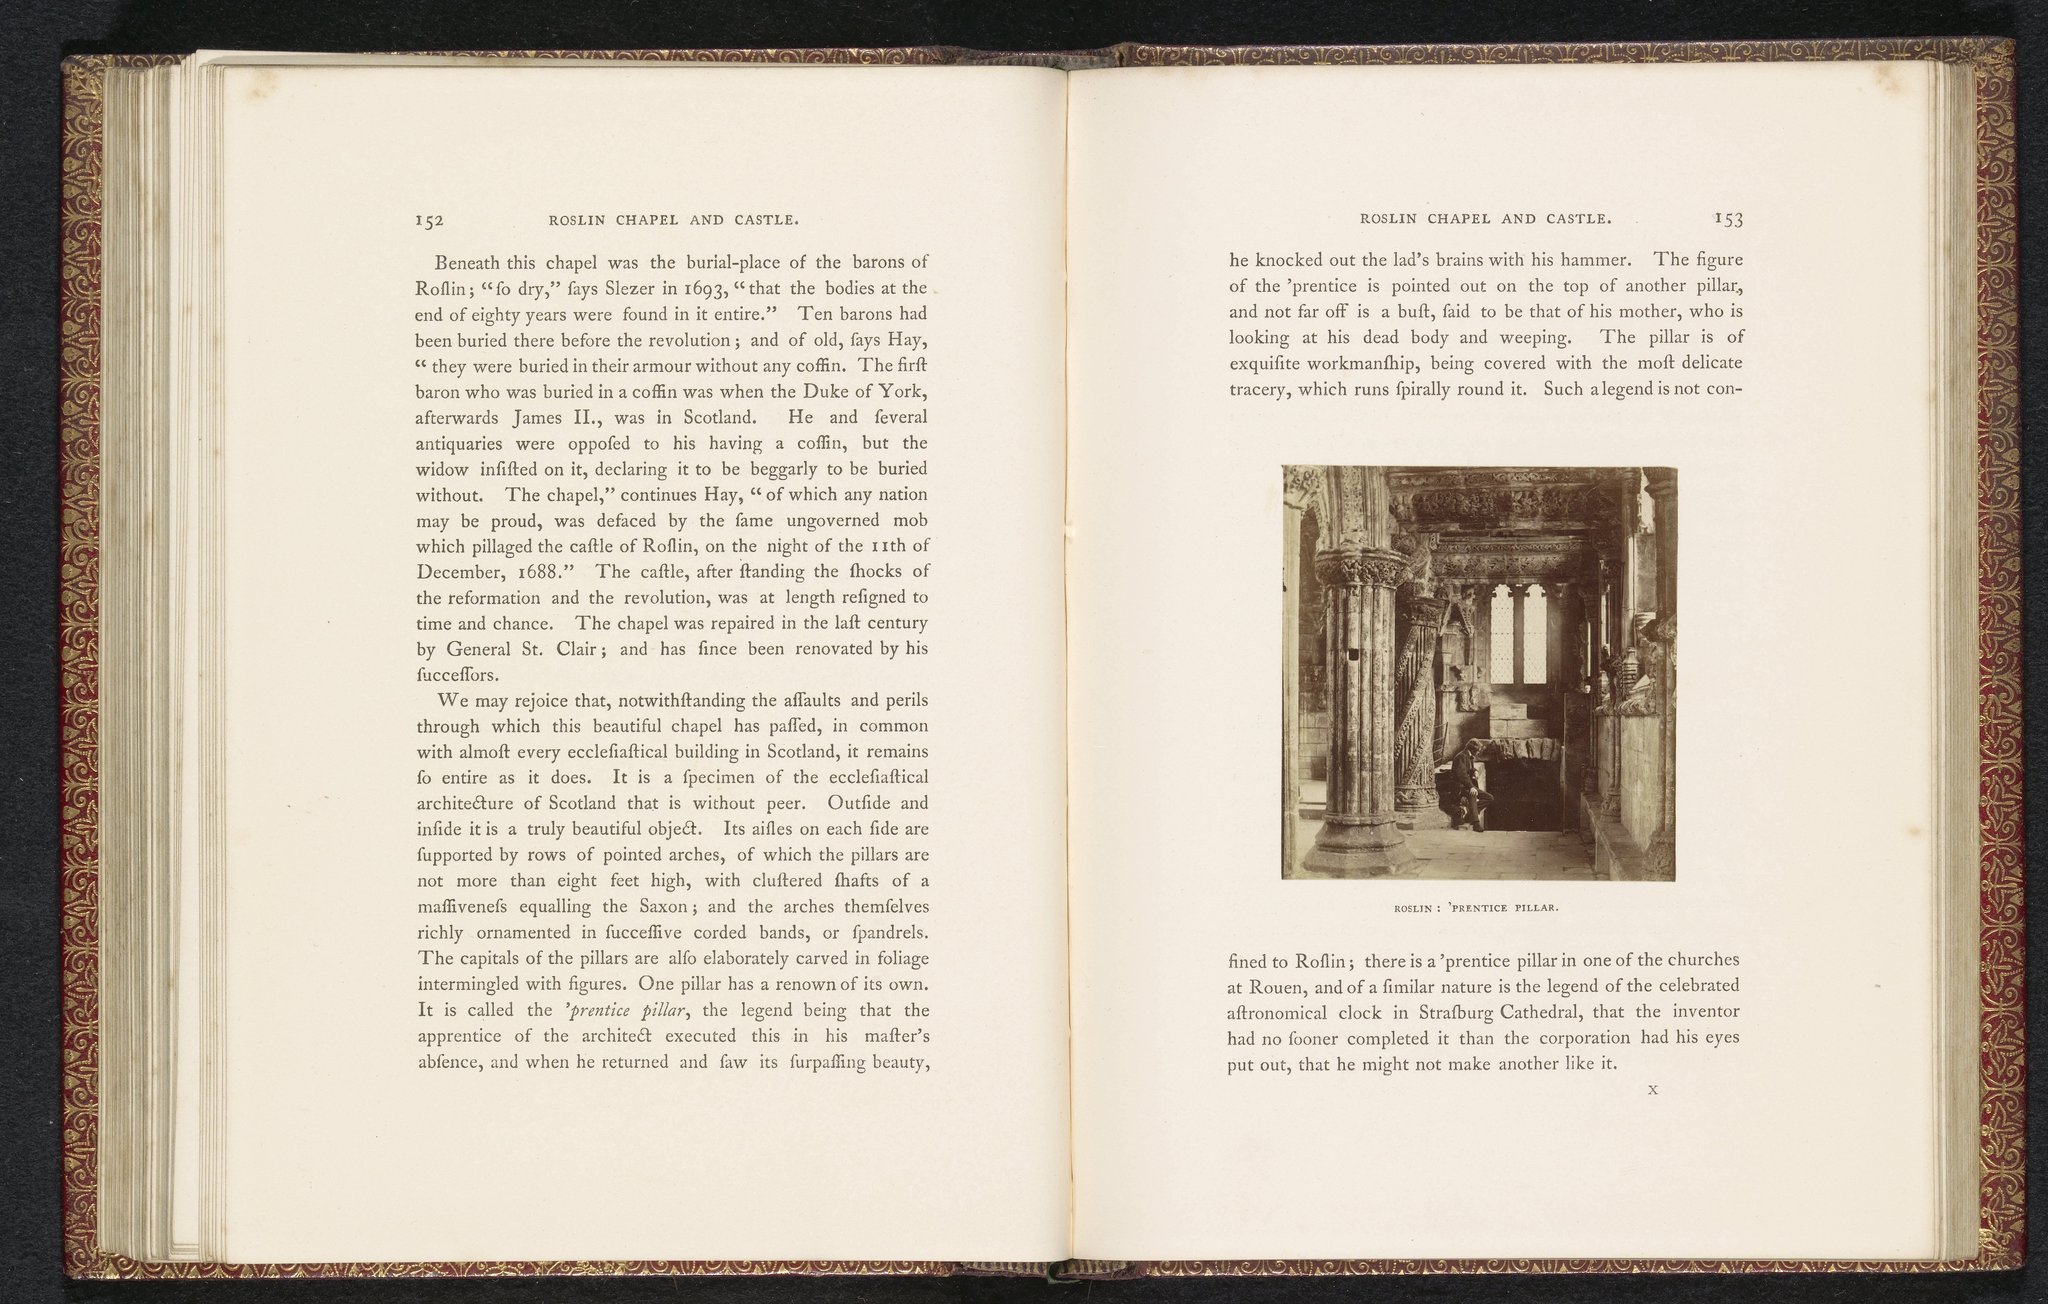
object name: page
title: Roslin : 'Prentice Pillar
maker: george washington wilson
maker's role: publisher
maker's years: 1823-1893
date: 1852-1862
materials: photographic support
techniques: albumen print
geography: rosslyn chapel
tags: parts of church exterior and annexes: chapel, column, pillar ~ architecture, ruin of church, monastery, etc.